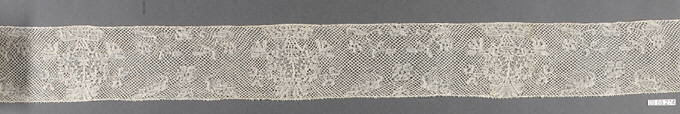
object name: piece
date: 1701-1733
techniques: lace